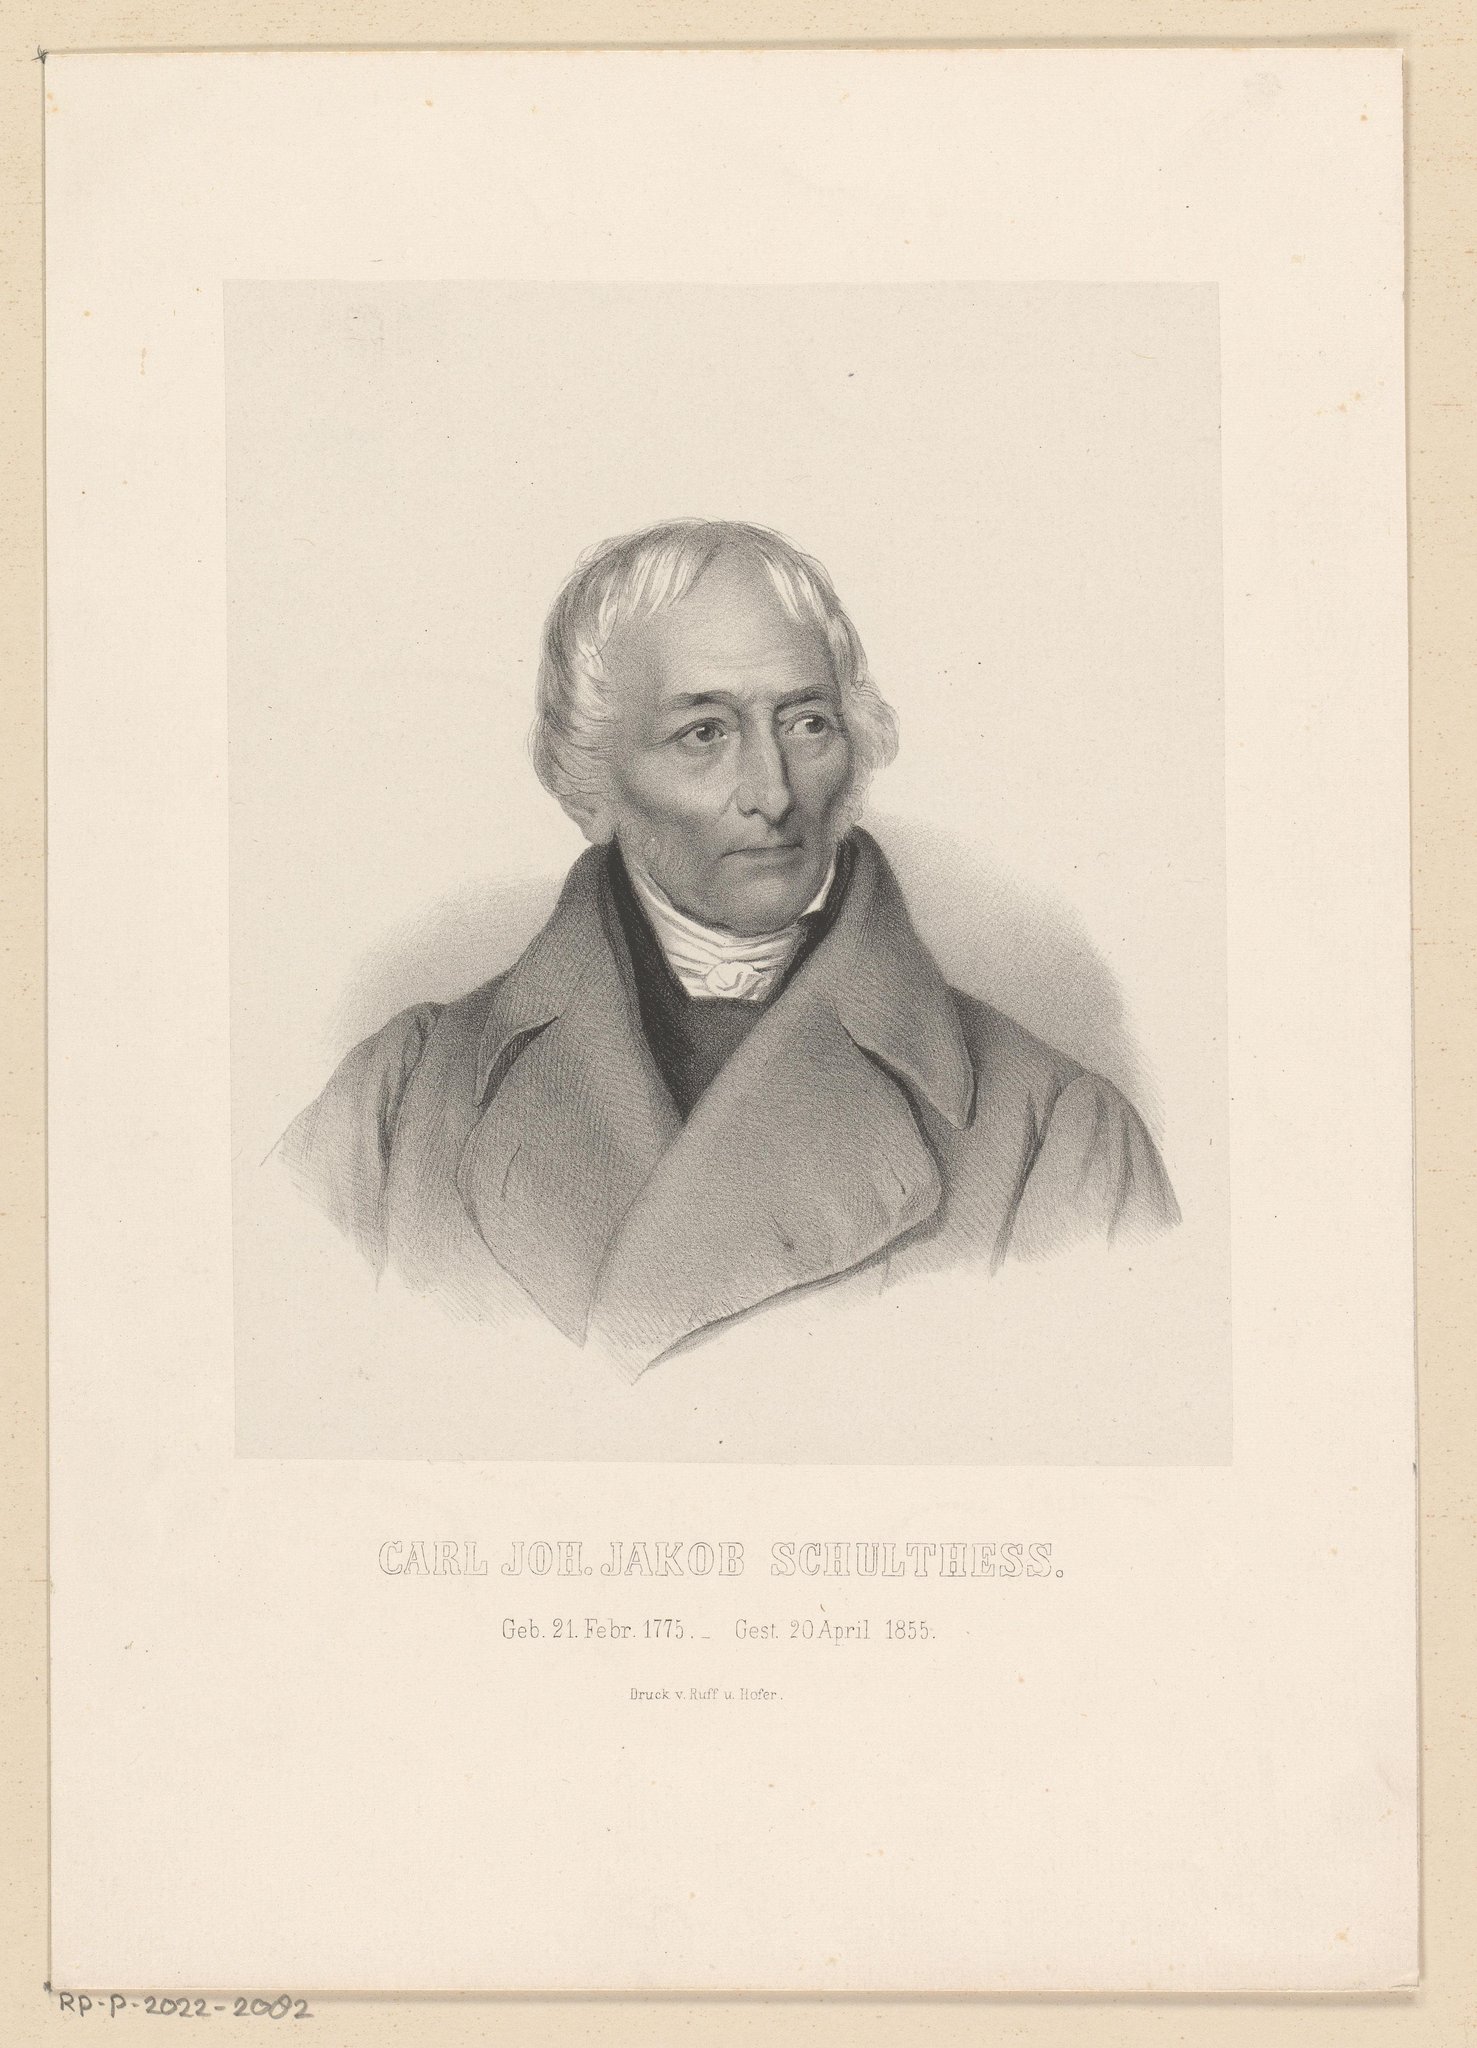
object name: print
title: Portret van Carl Johann Jakob Schulthess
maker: Anonymous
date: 1856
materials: paper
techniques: lithograph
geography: zurich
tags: draughtsman, carl johann jakob schulthess, historical persons, portrait, self-portrait of artist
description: Prent waarschijnlijk uit: Neujahrsblatt 16 (1856).